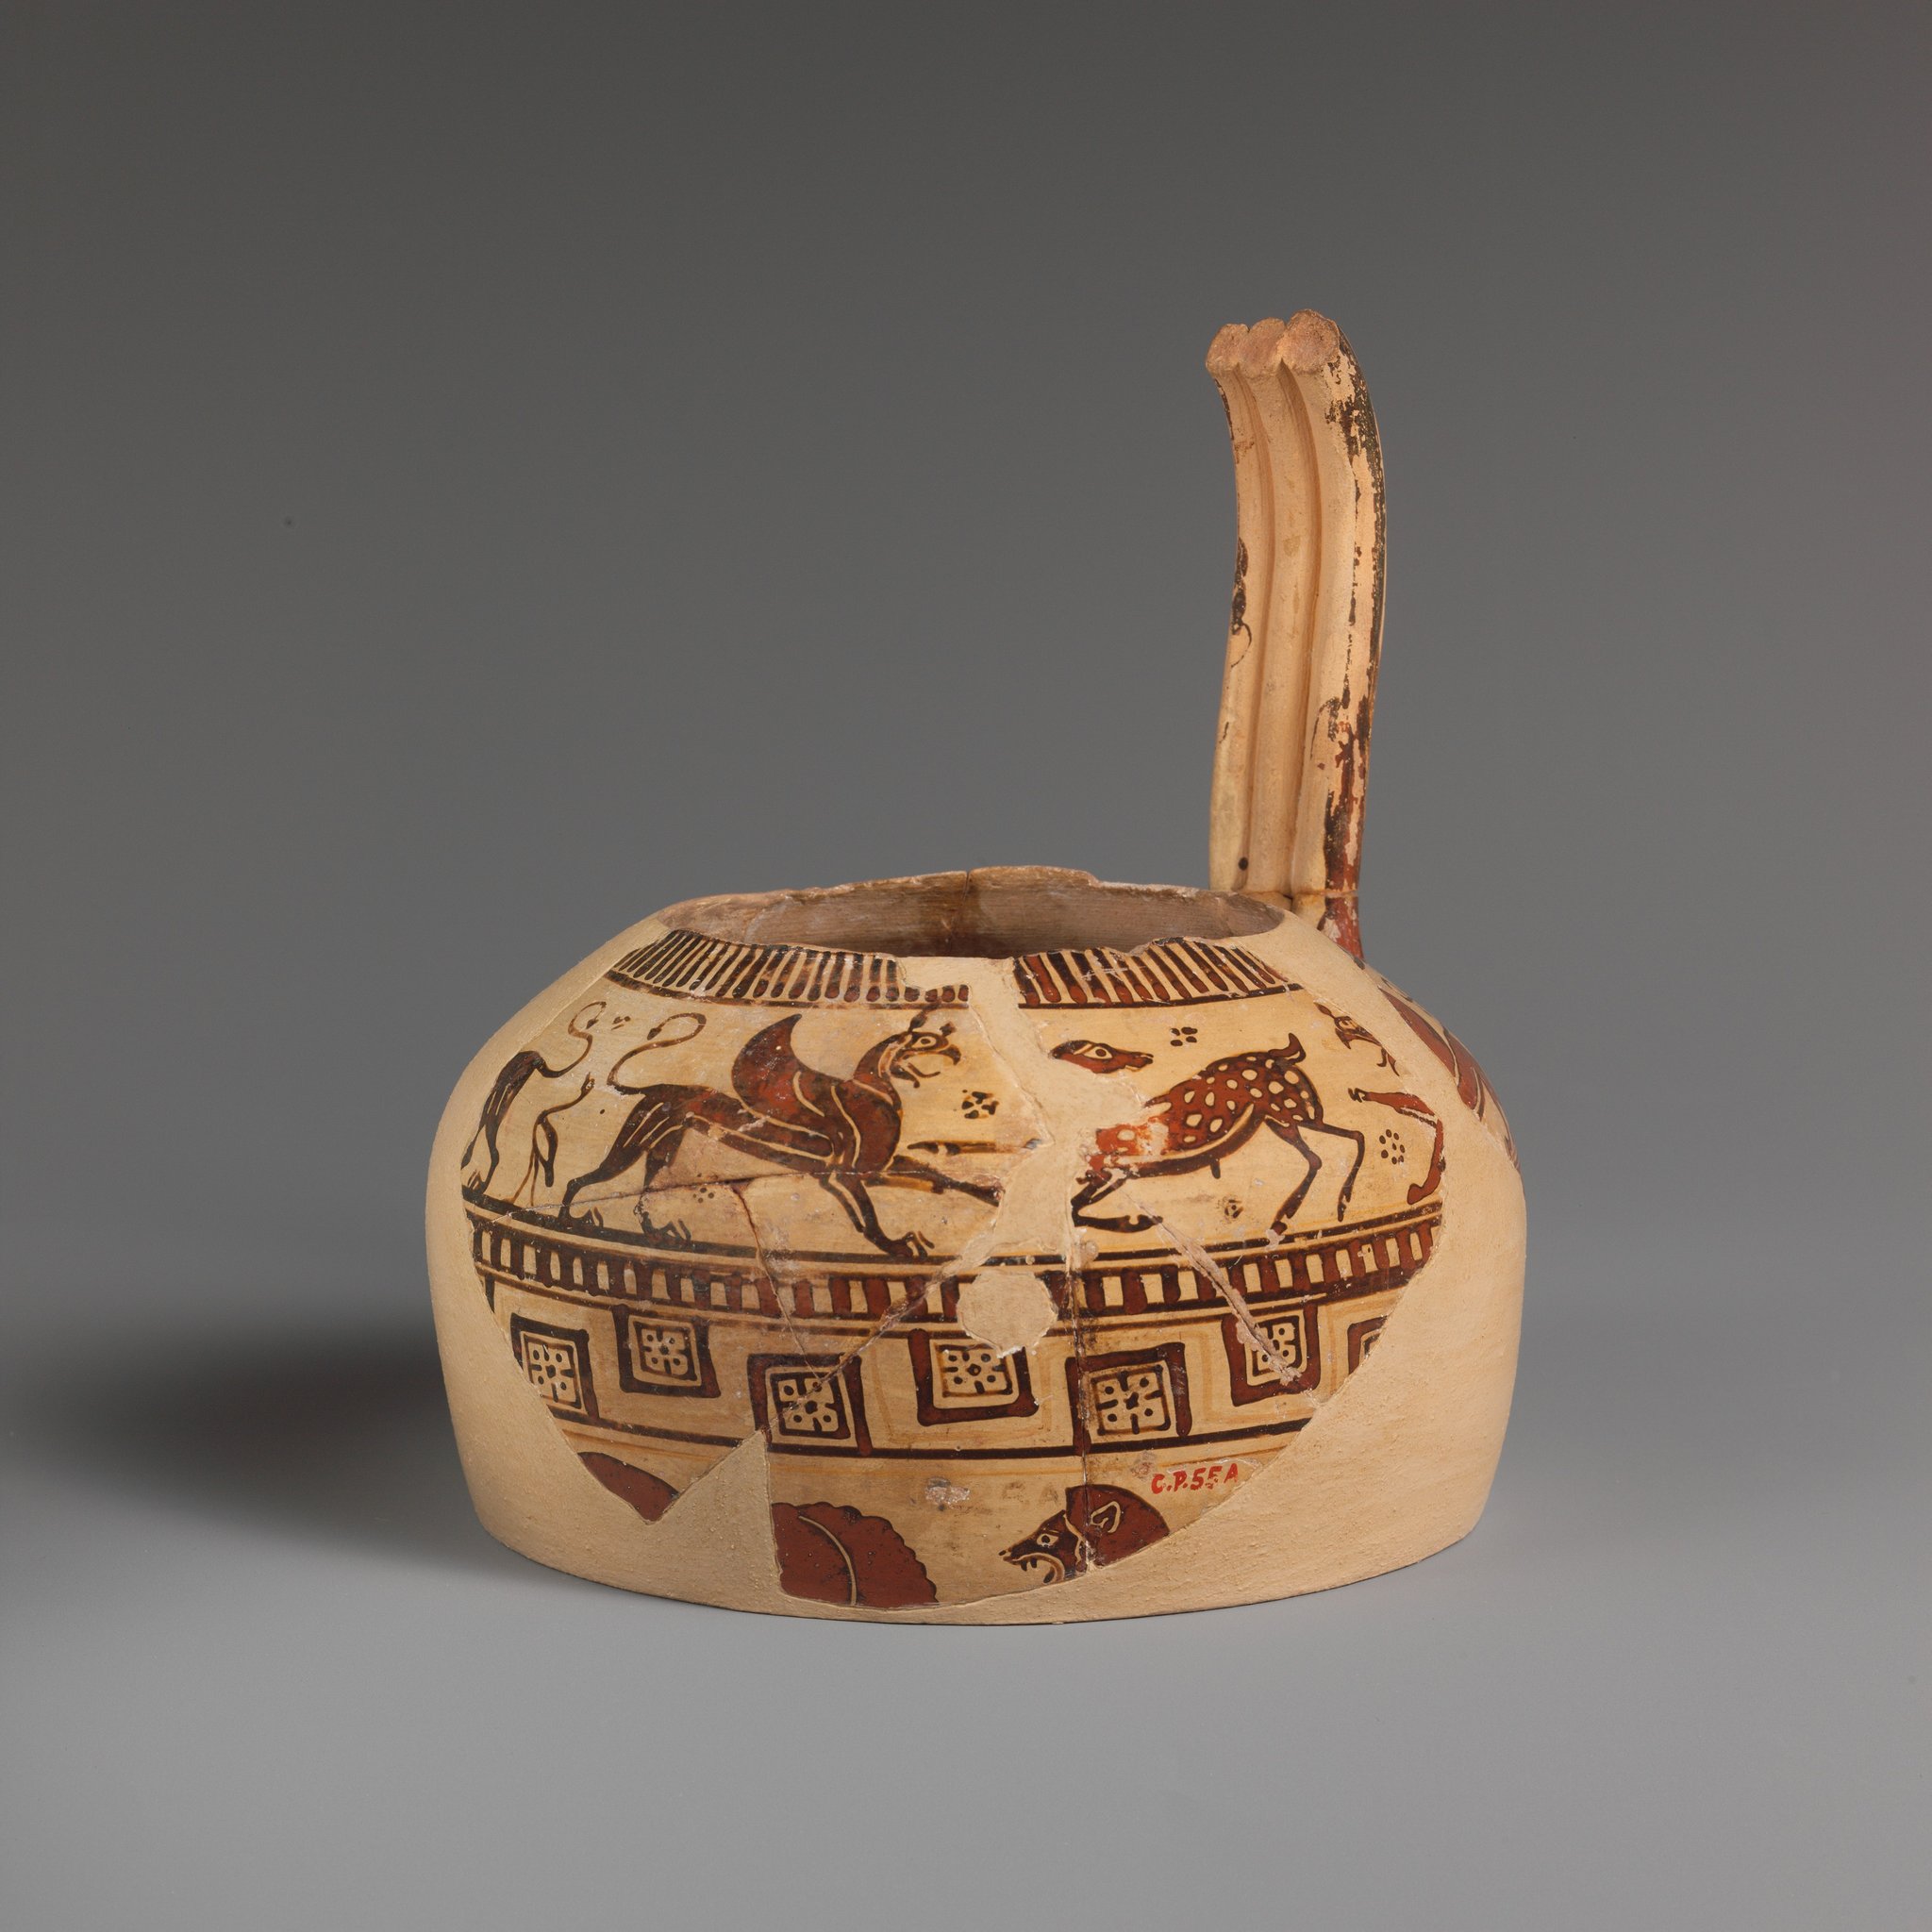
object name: oinochoe, fragmentary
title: Fragment of a terracotta oinochoe (jug)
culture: greek, east, milesian, fikellura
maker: altenburg painter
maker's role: artist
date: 560-550 BCE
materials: terracotta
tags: birds,griffins,sphinx,deer,lions